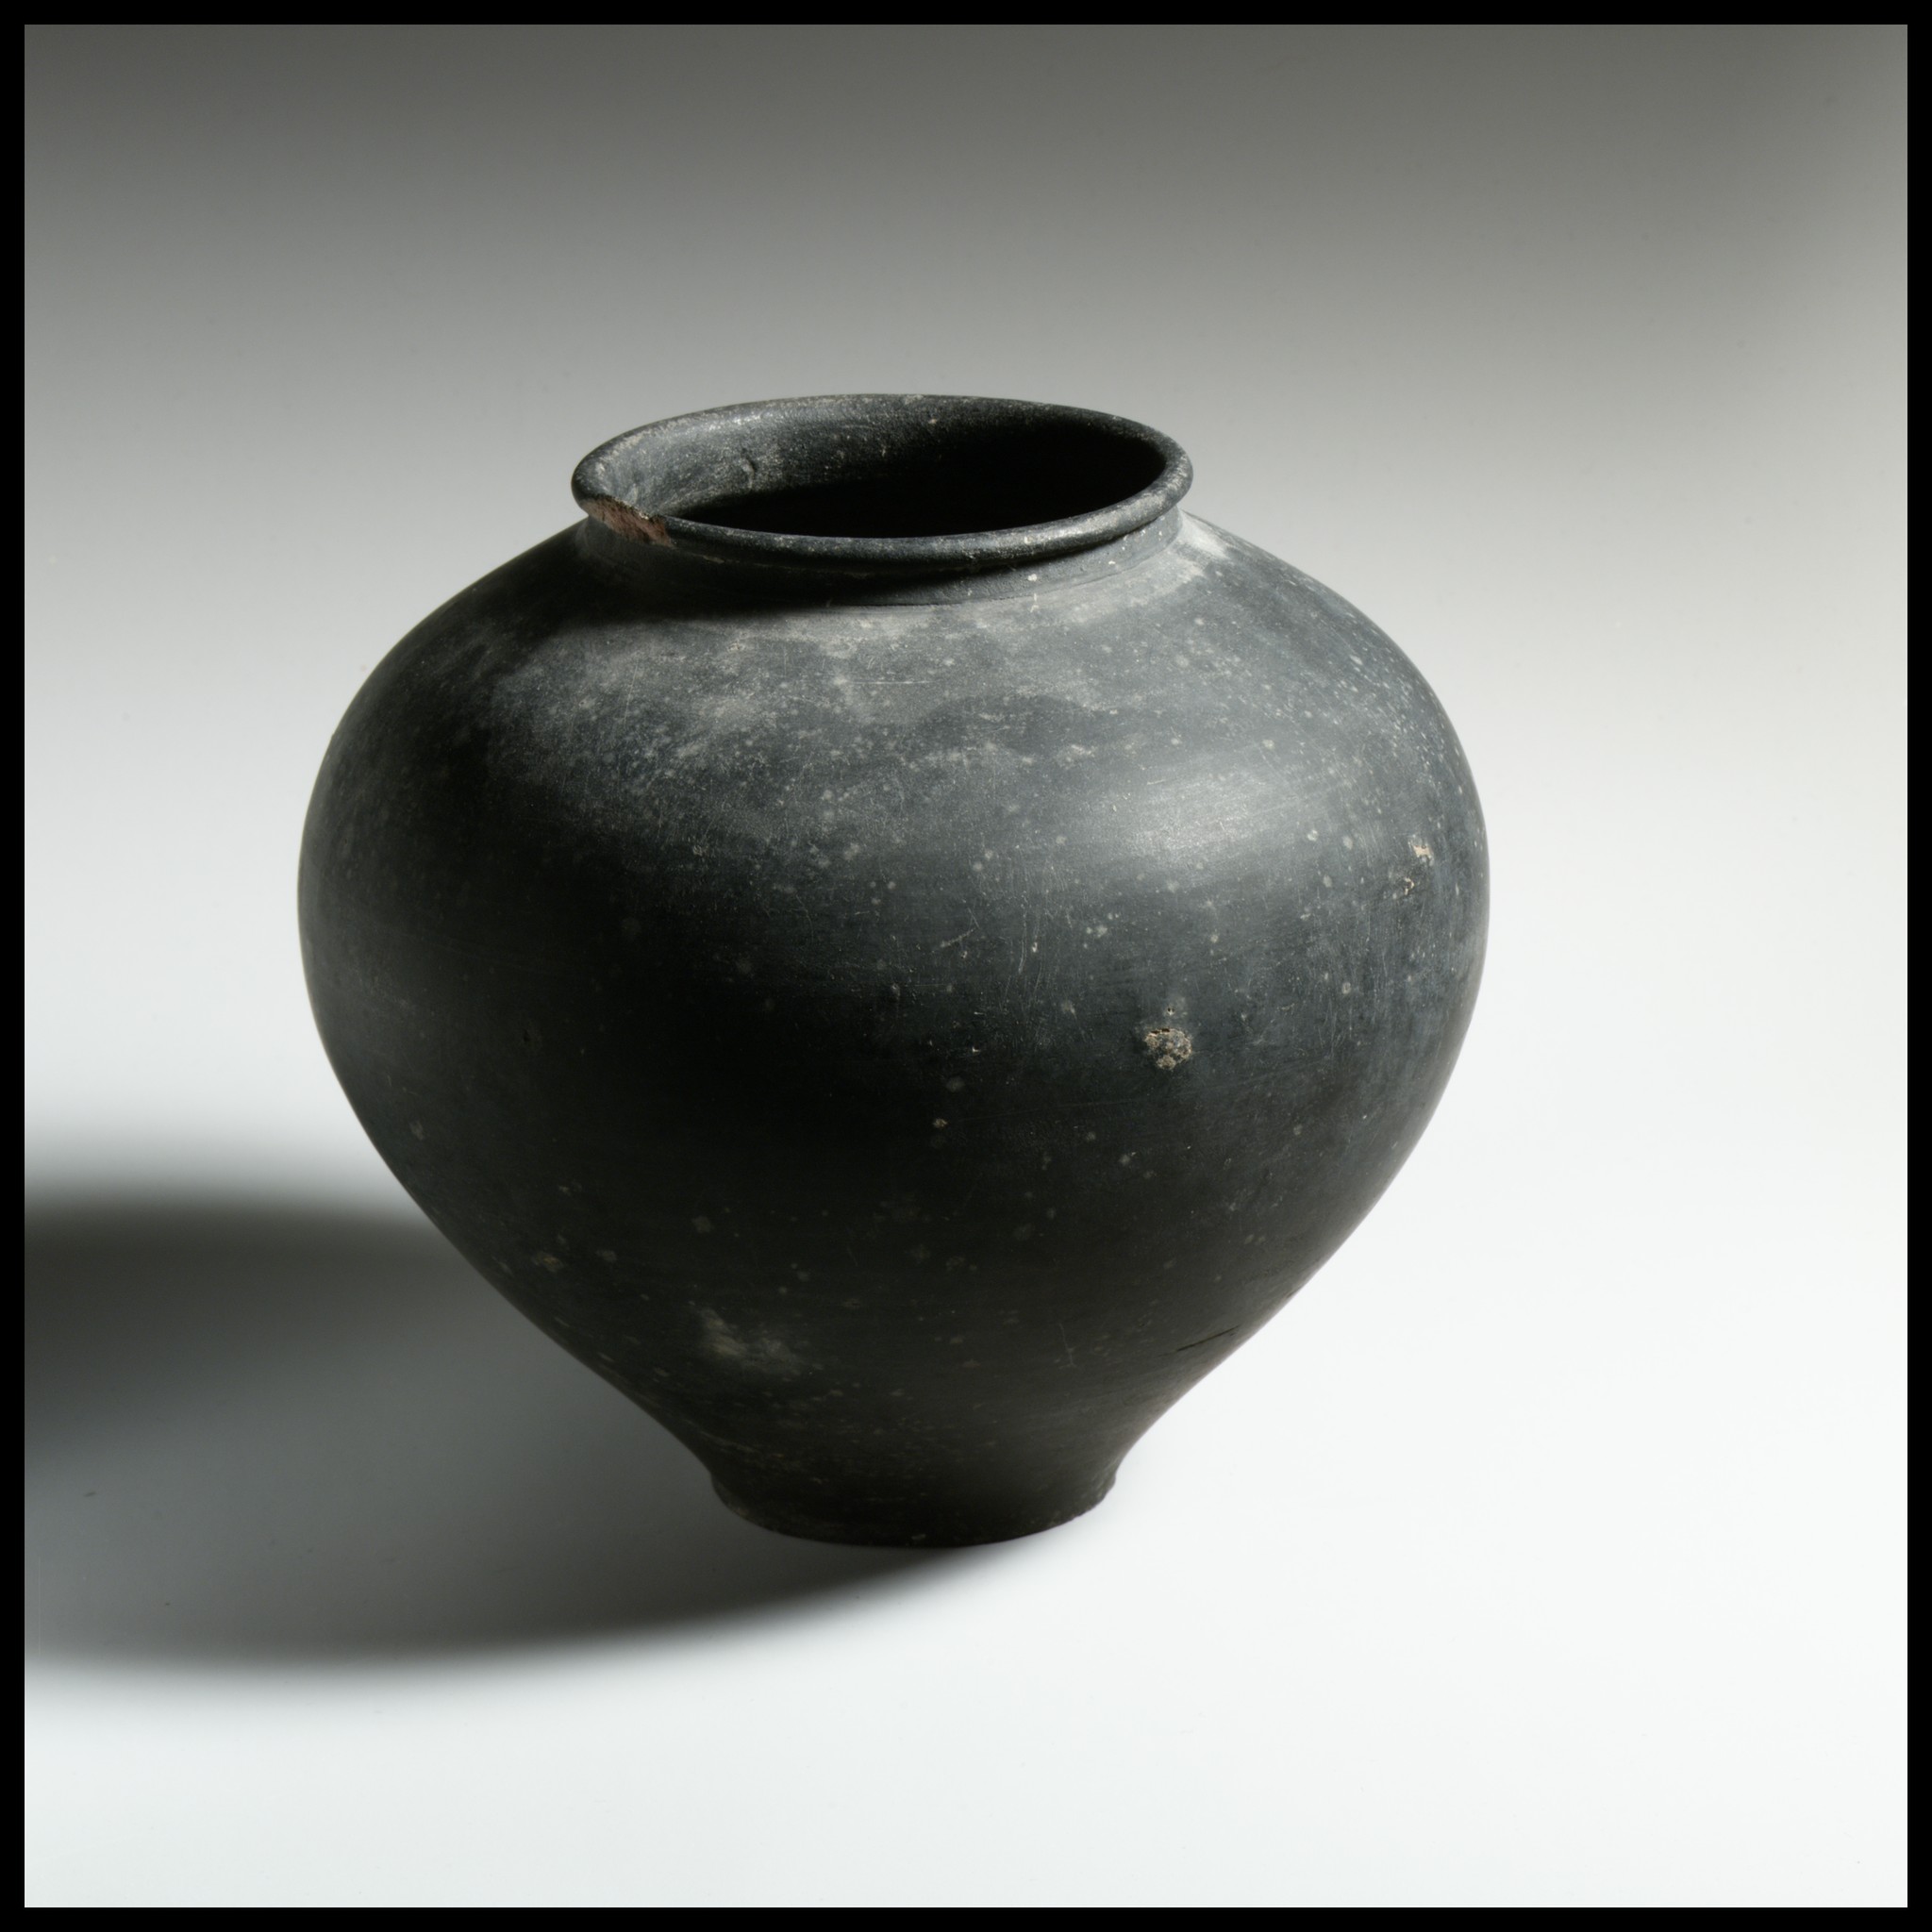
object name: jar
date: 7000 BCE-330 CE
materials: terracotta